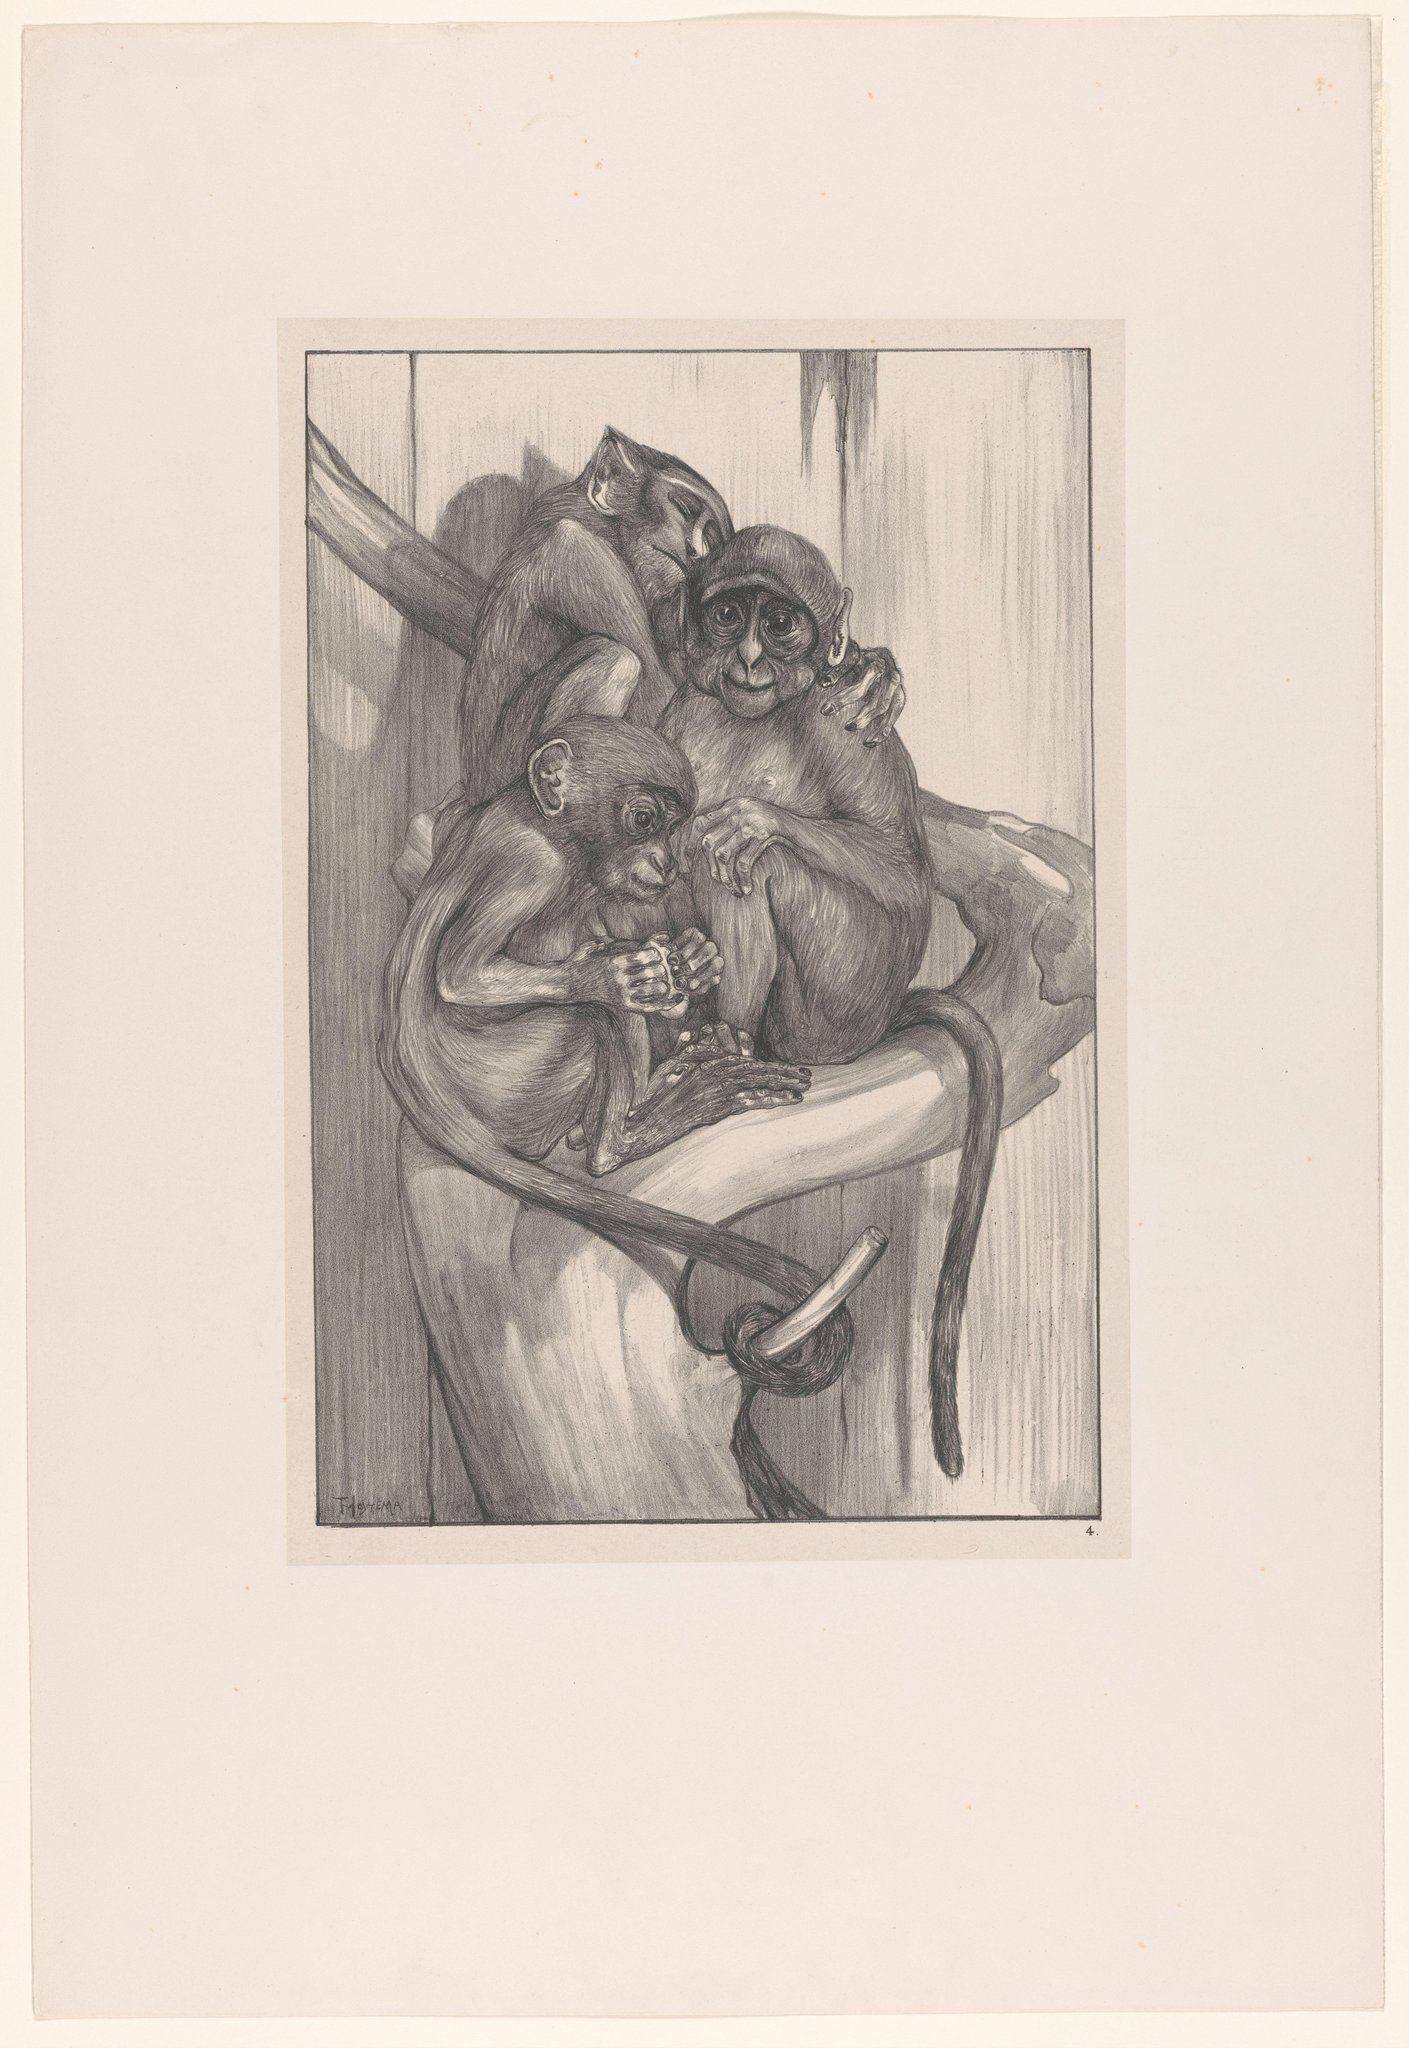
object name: print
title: Drie apen op een boomstronk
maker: theo van hoytema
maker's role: draughtsman, painter, print maker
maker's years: 1863-1917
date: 1898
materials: paper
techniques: lithograph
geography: hilversum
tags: monkeys, apes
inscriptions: collector's mark: Lugt 2233